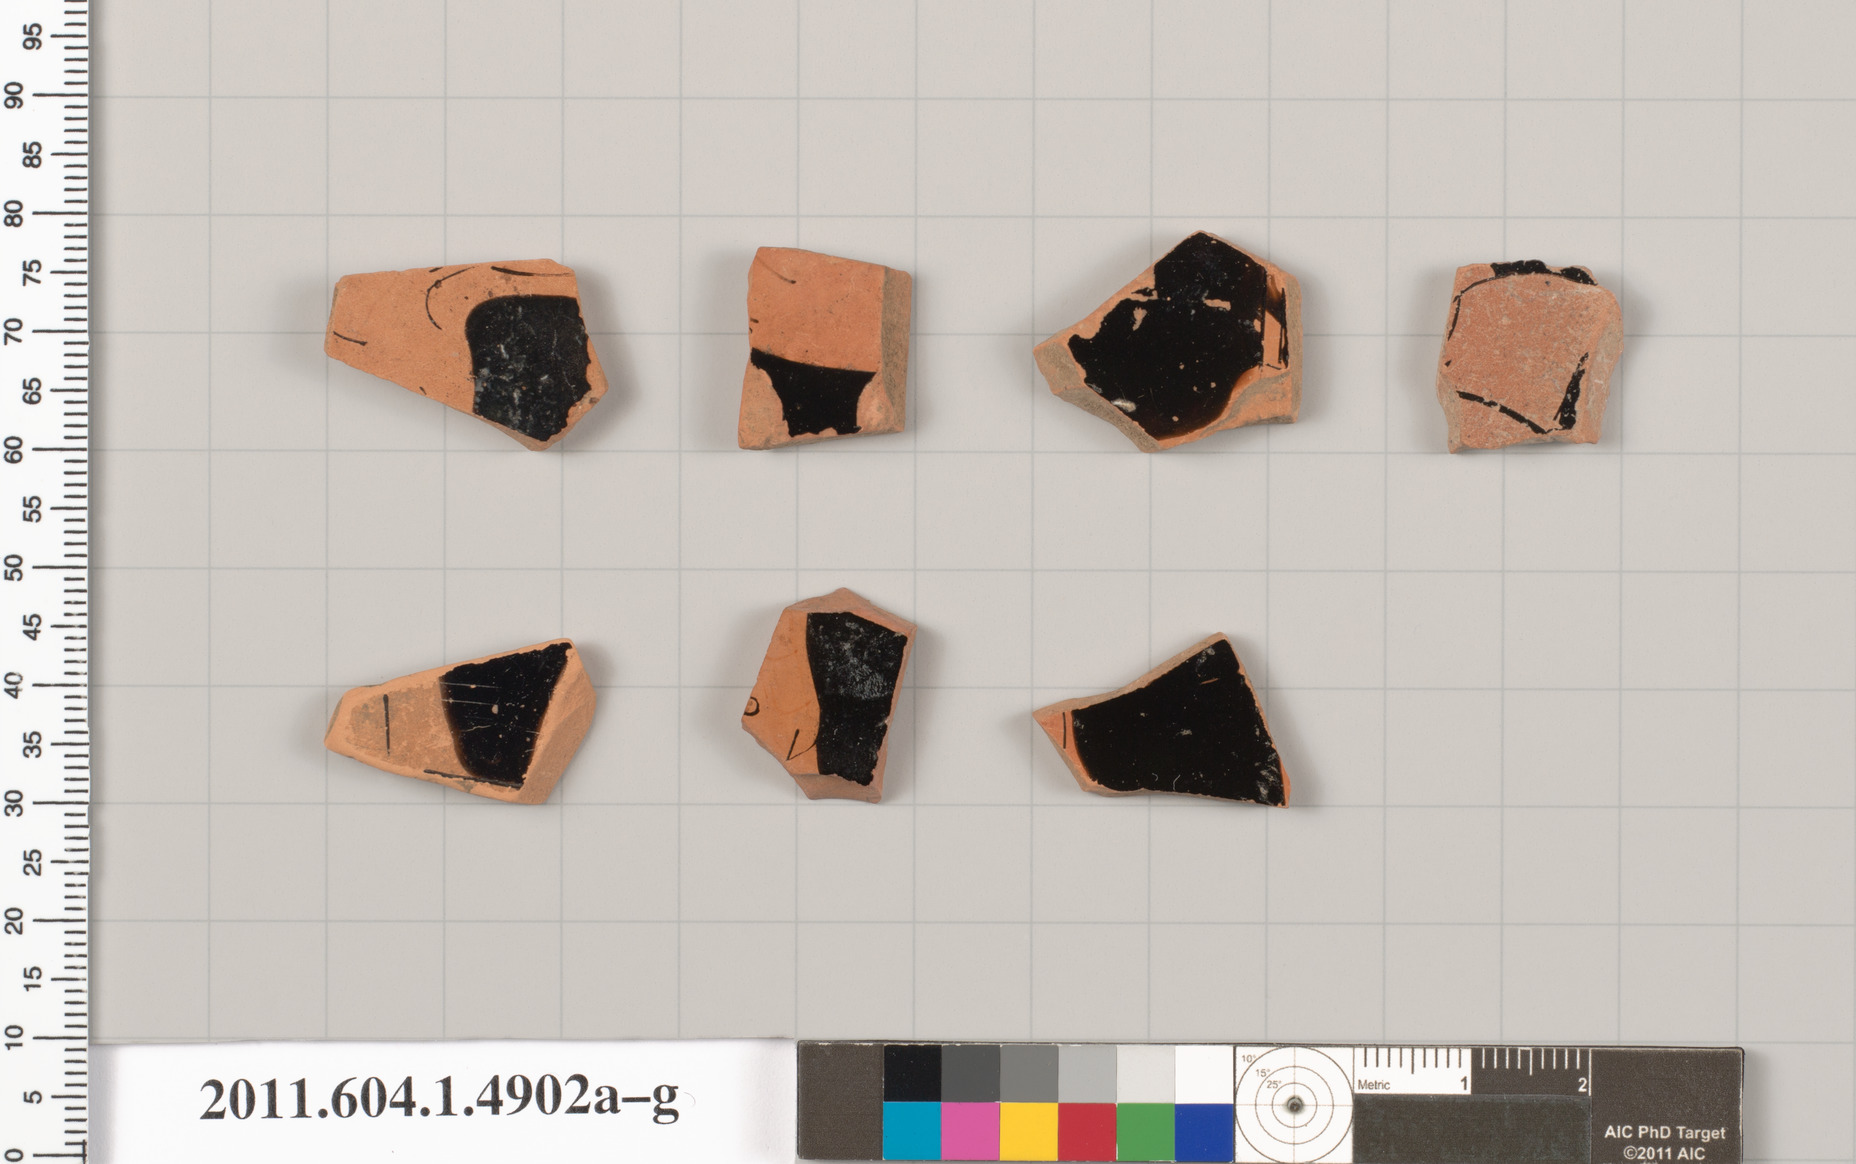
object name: kylix fragment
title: Terracotta fragments of kylikes (drinking cups)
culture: greek, attic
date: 475-451 BCE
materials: terracotta